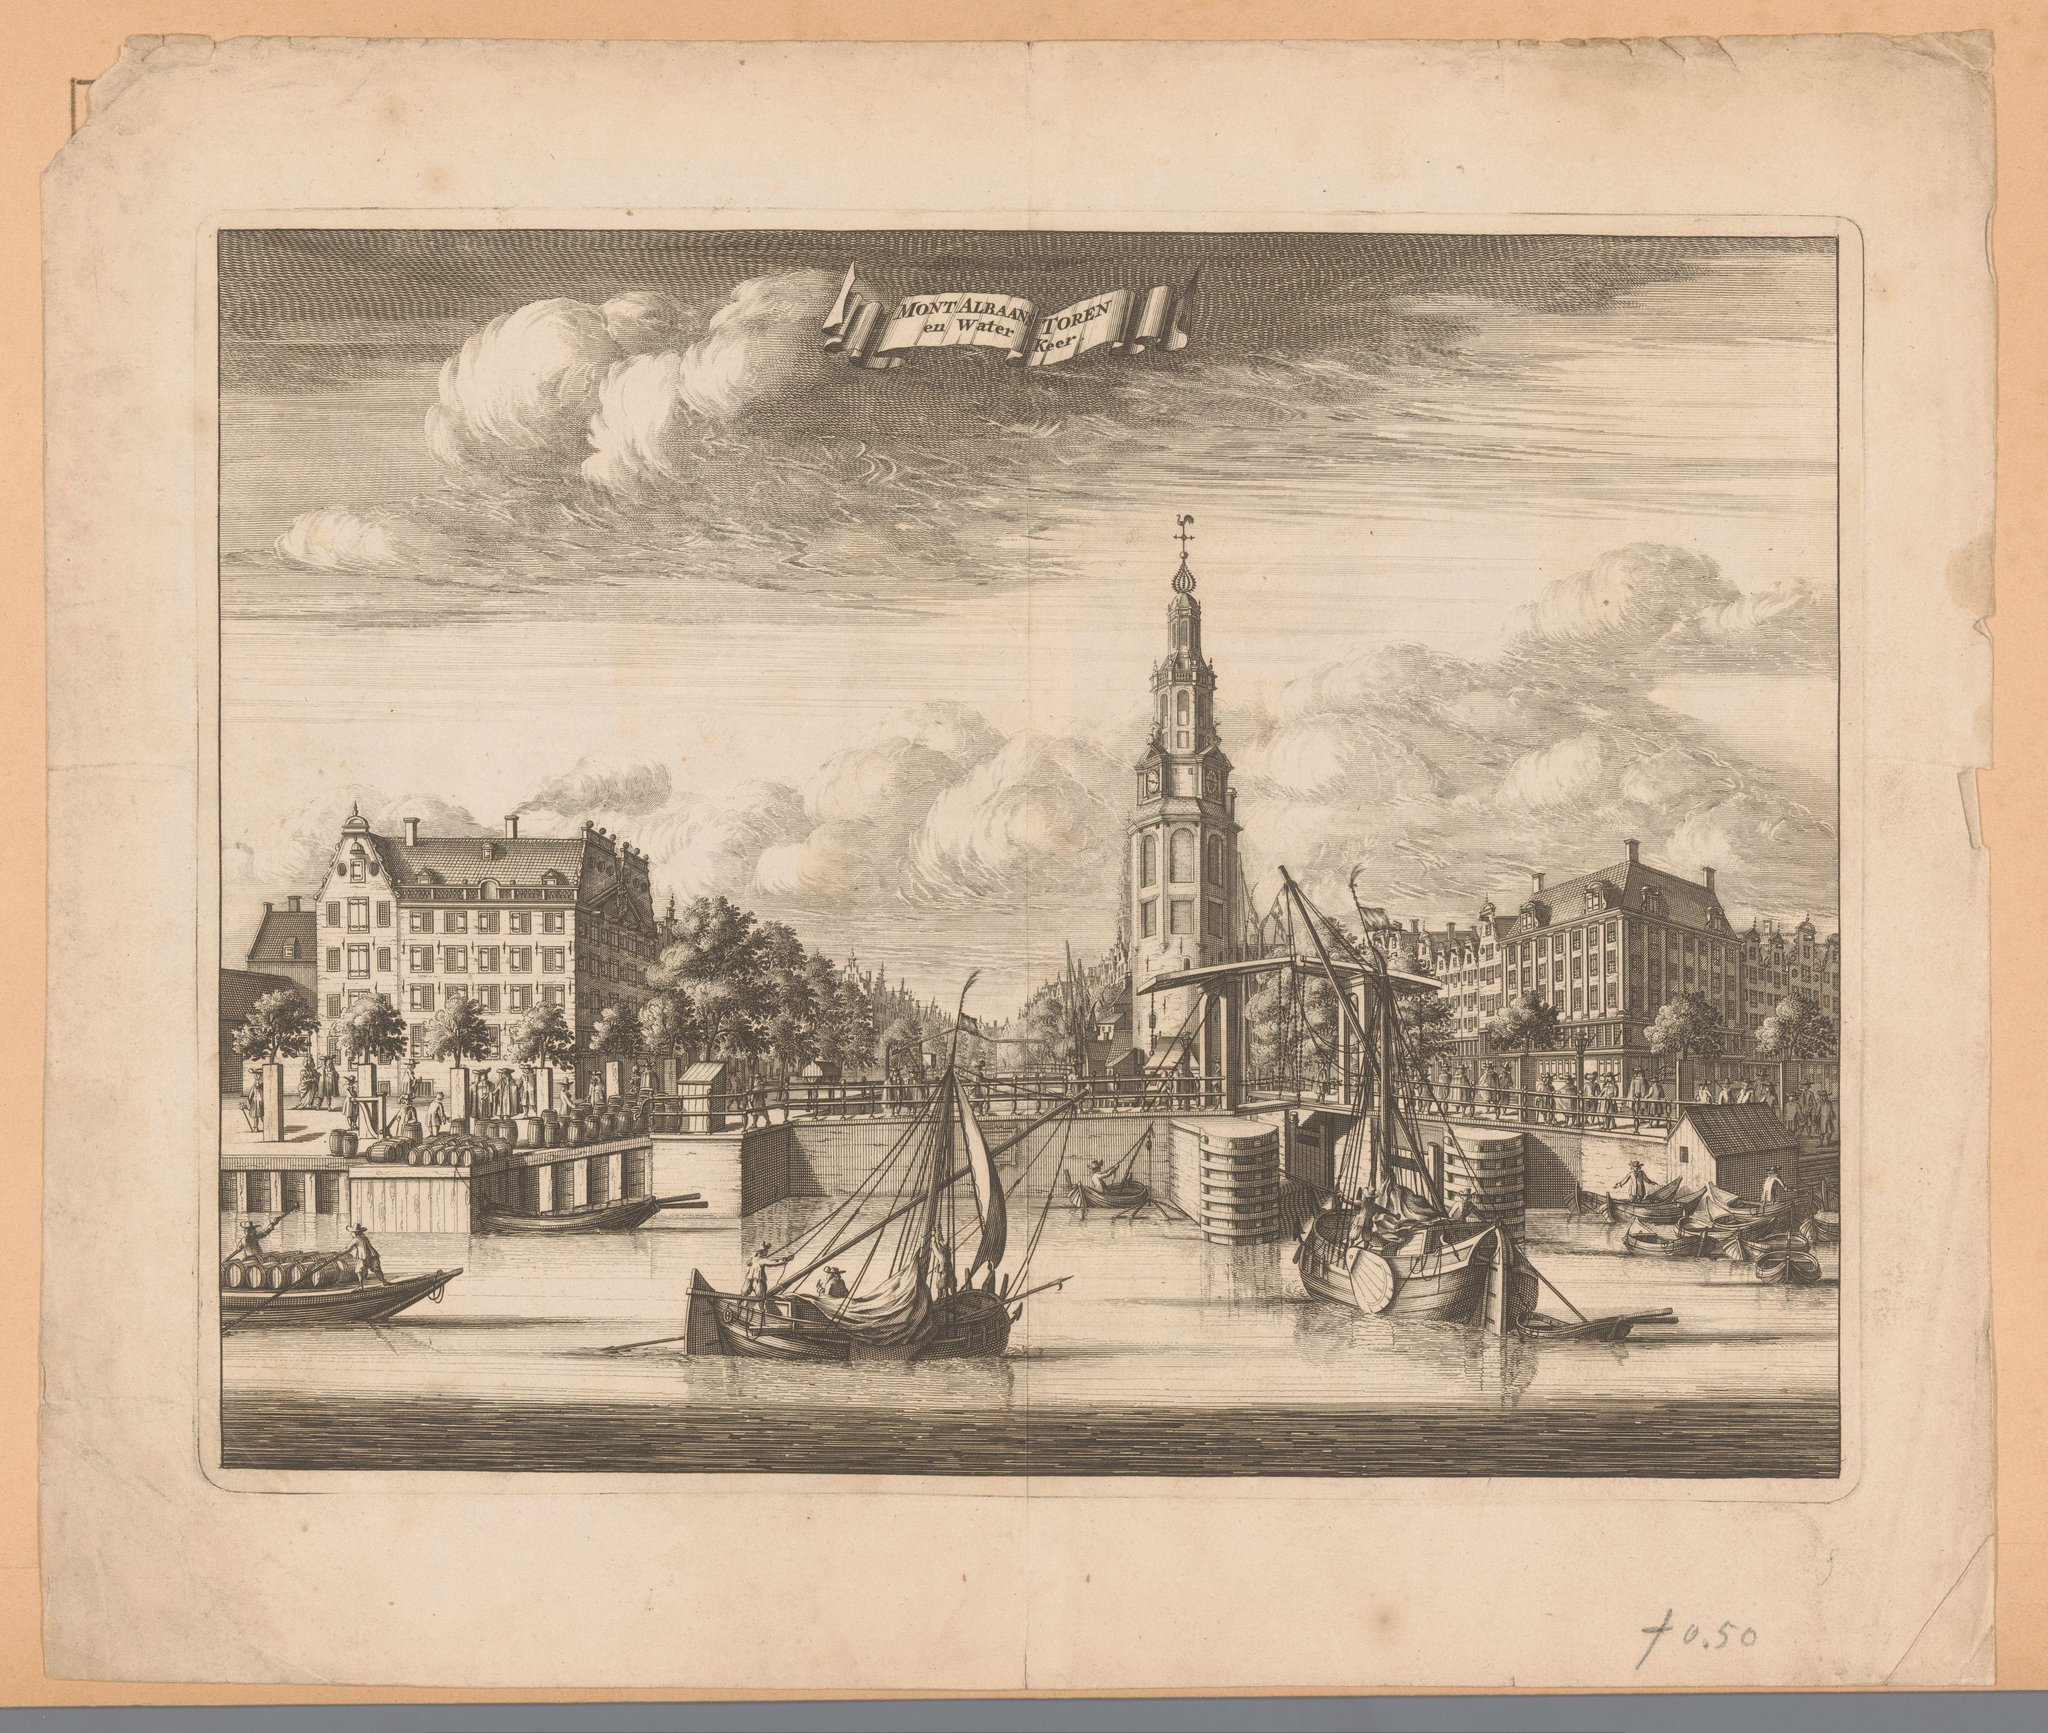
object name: book illustration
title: Gezicht op de Montelbaanstoren te Amsterdam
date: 1693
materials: paper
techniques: etching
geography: amsterdam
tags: sluice, weir, tower, clock tower ~ monumental adornment, canals, waters (in city) (+ city(-scape) with figures, staffage)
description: Prent uit: Commelin, Caspar. Beschryvinge van Amsterdam, desselfs eerste oorspronk uyt den Huyse (…). Amsterdam: Abraham Wolfgang et al., 1693, tussen p. 706 en 707. Of uit: Commelin, Caspar. Beschryvinge van Amsterdam, zynde een naukeurige verhandelinge van desselfs eerste oorspronk uyt (…). Amsterdam: weduwe Aart Dircksz Oossaan, 1694. Latere staat gebruikt in: Commelin, Caspar. Beschryvinge van Amsterdam, zynde een naukeurige verhandelinge van desselfs eerste oorspronk uyt (…). Amsterdam: Andries van Damme et al., 1726.